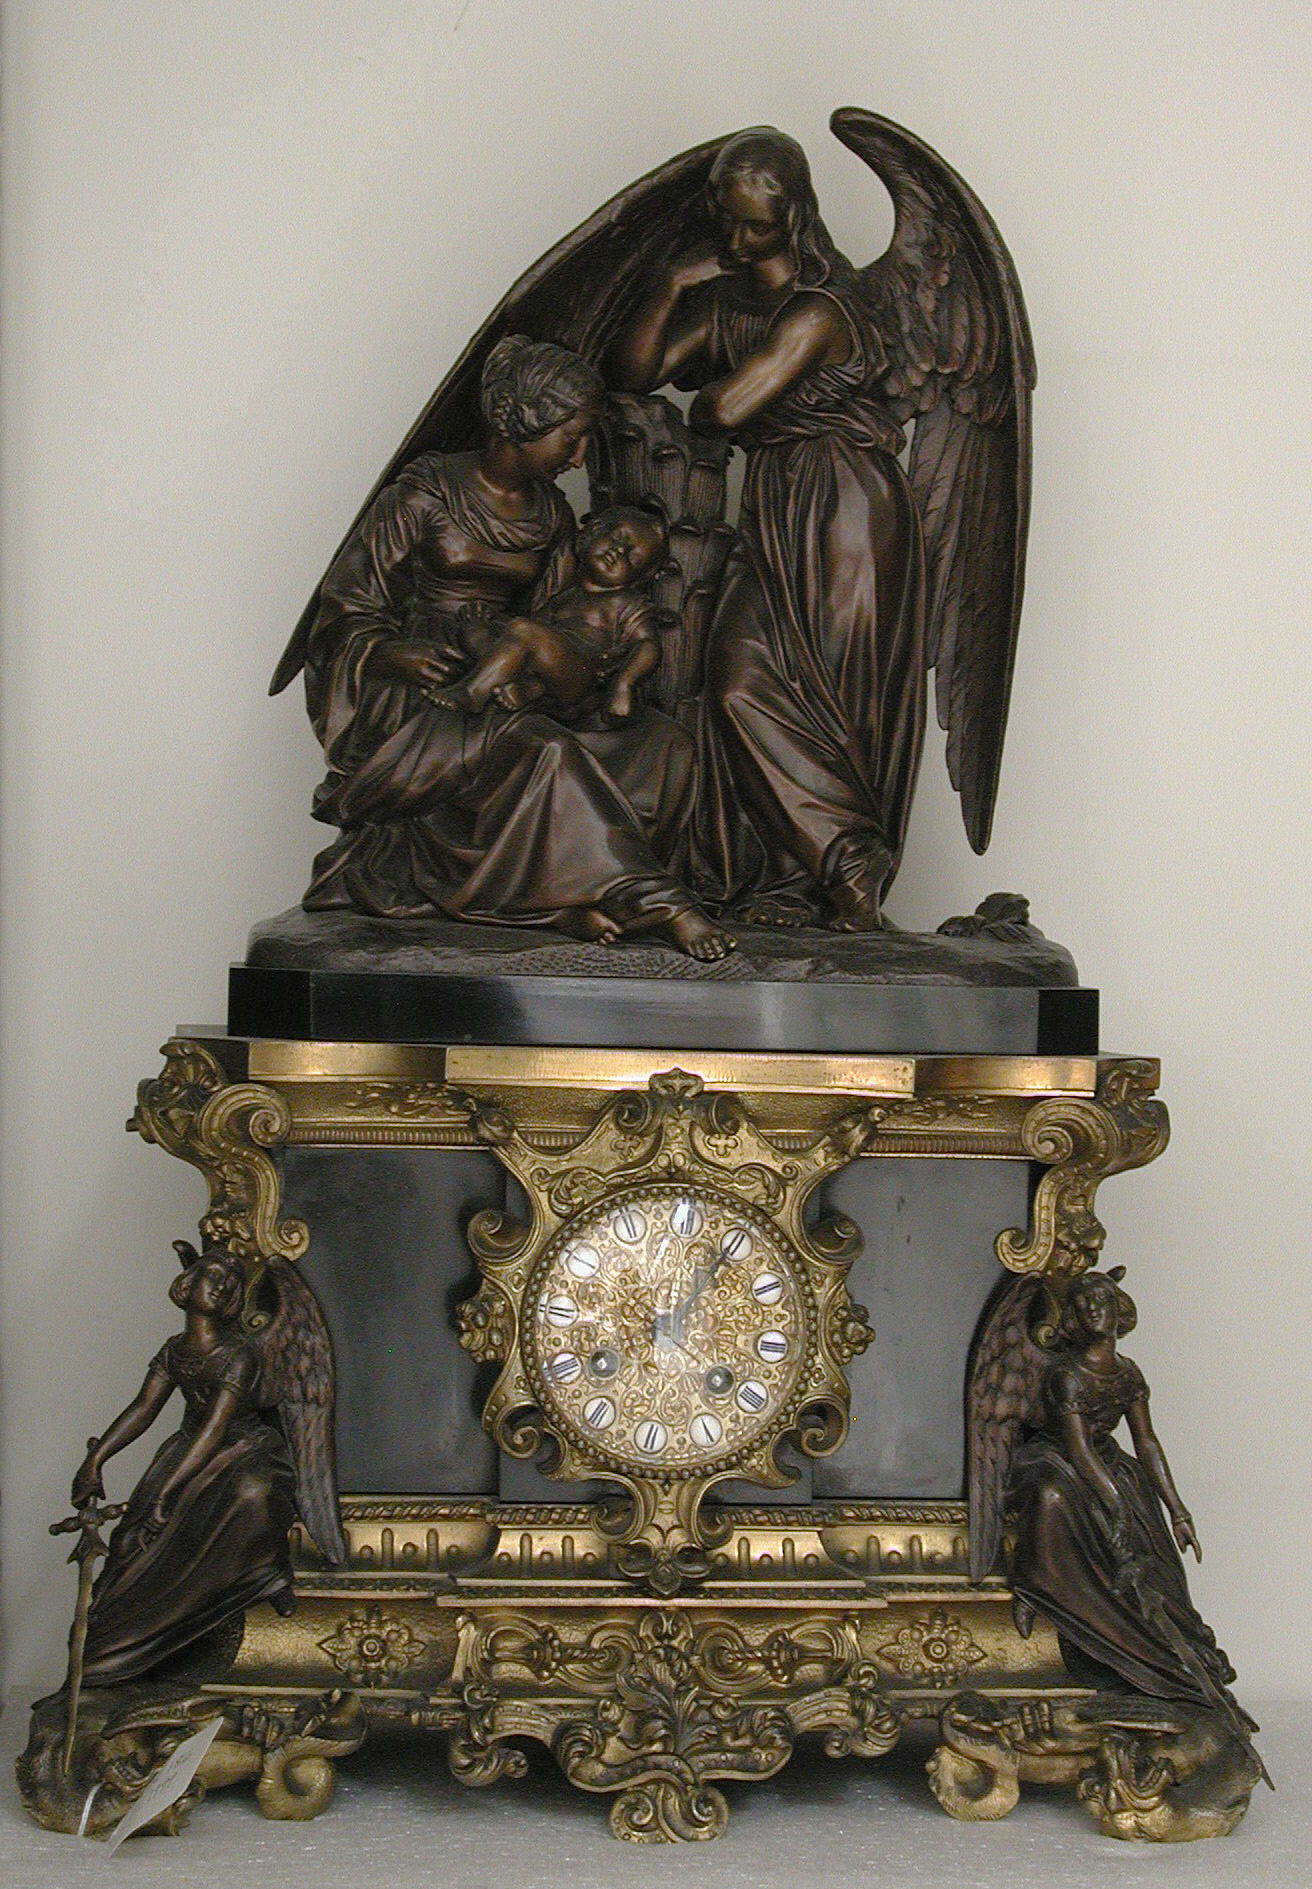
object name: mantel clock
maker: honoré pons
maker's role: maker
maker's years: 1802-1855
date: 1840-1850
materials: brass, bronze, enamel, gilt, glass, marble, steel, wood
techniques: gilding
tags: swords,angels,madonna and child